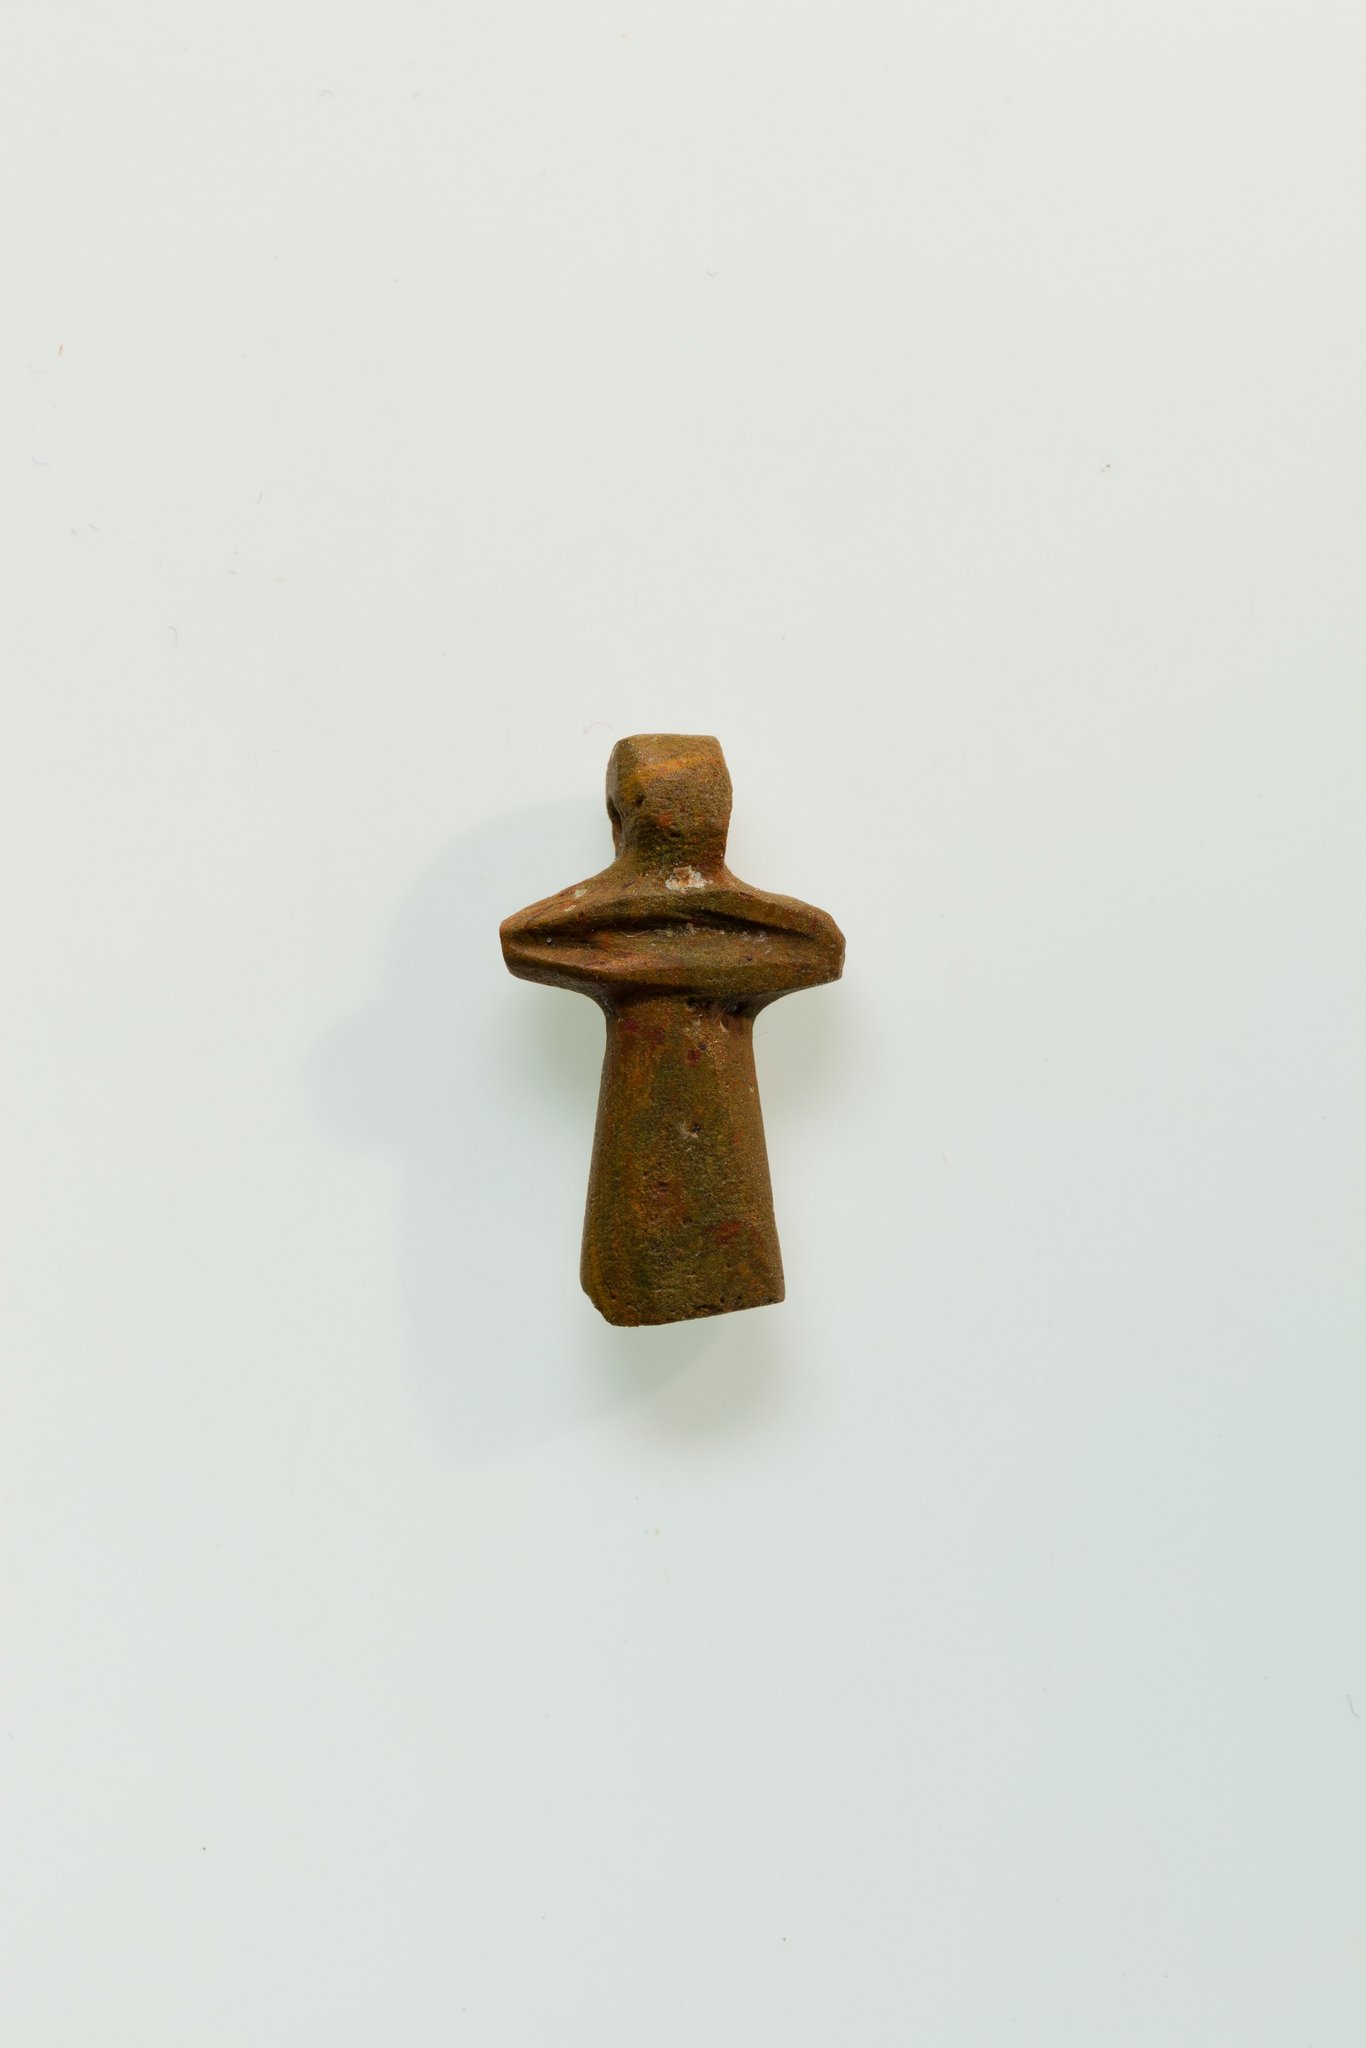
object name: amulet, djed pillar, tiye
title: Djed Pillar Amulet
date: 1070-945 BCE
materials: glass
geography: egypt